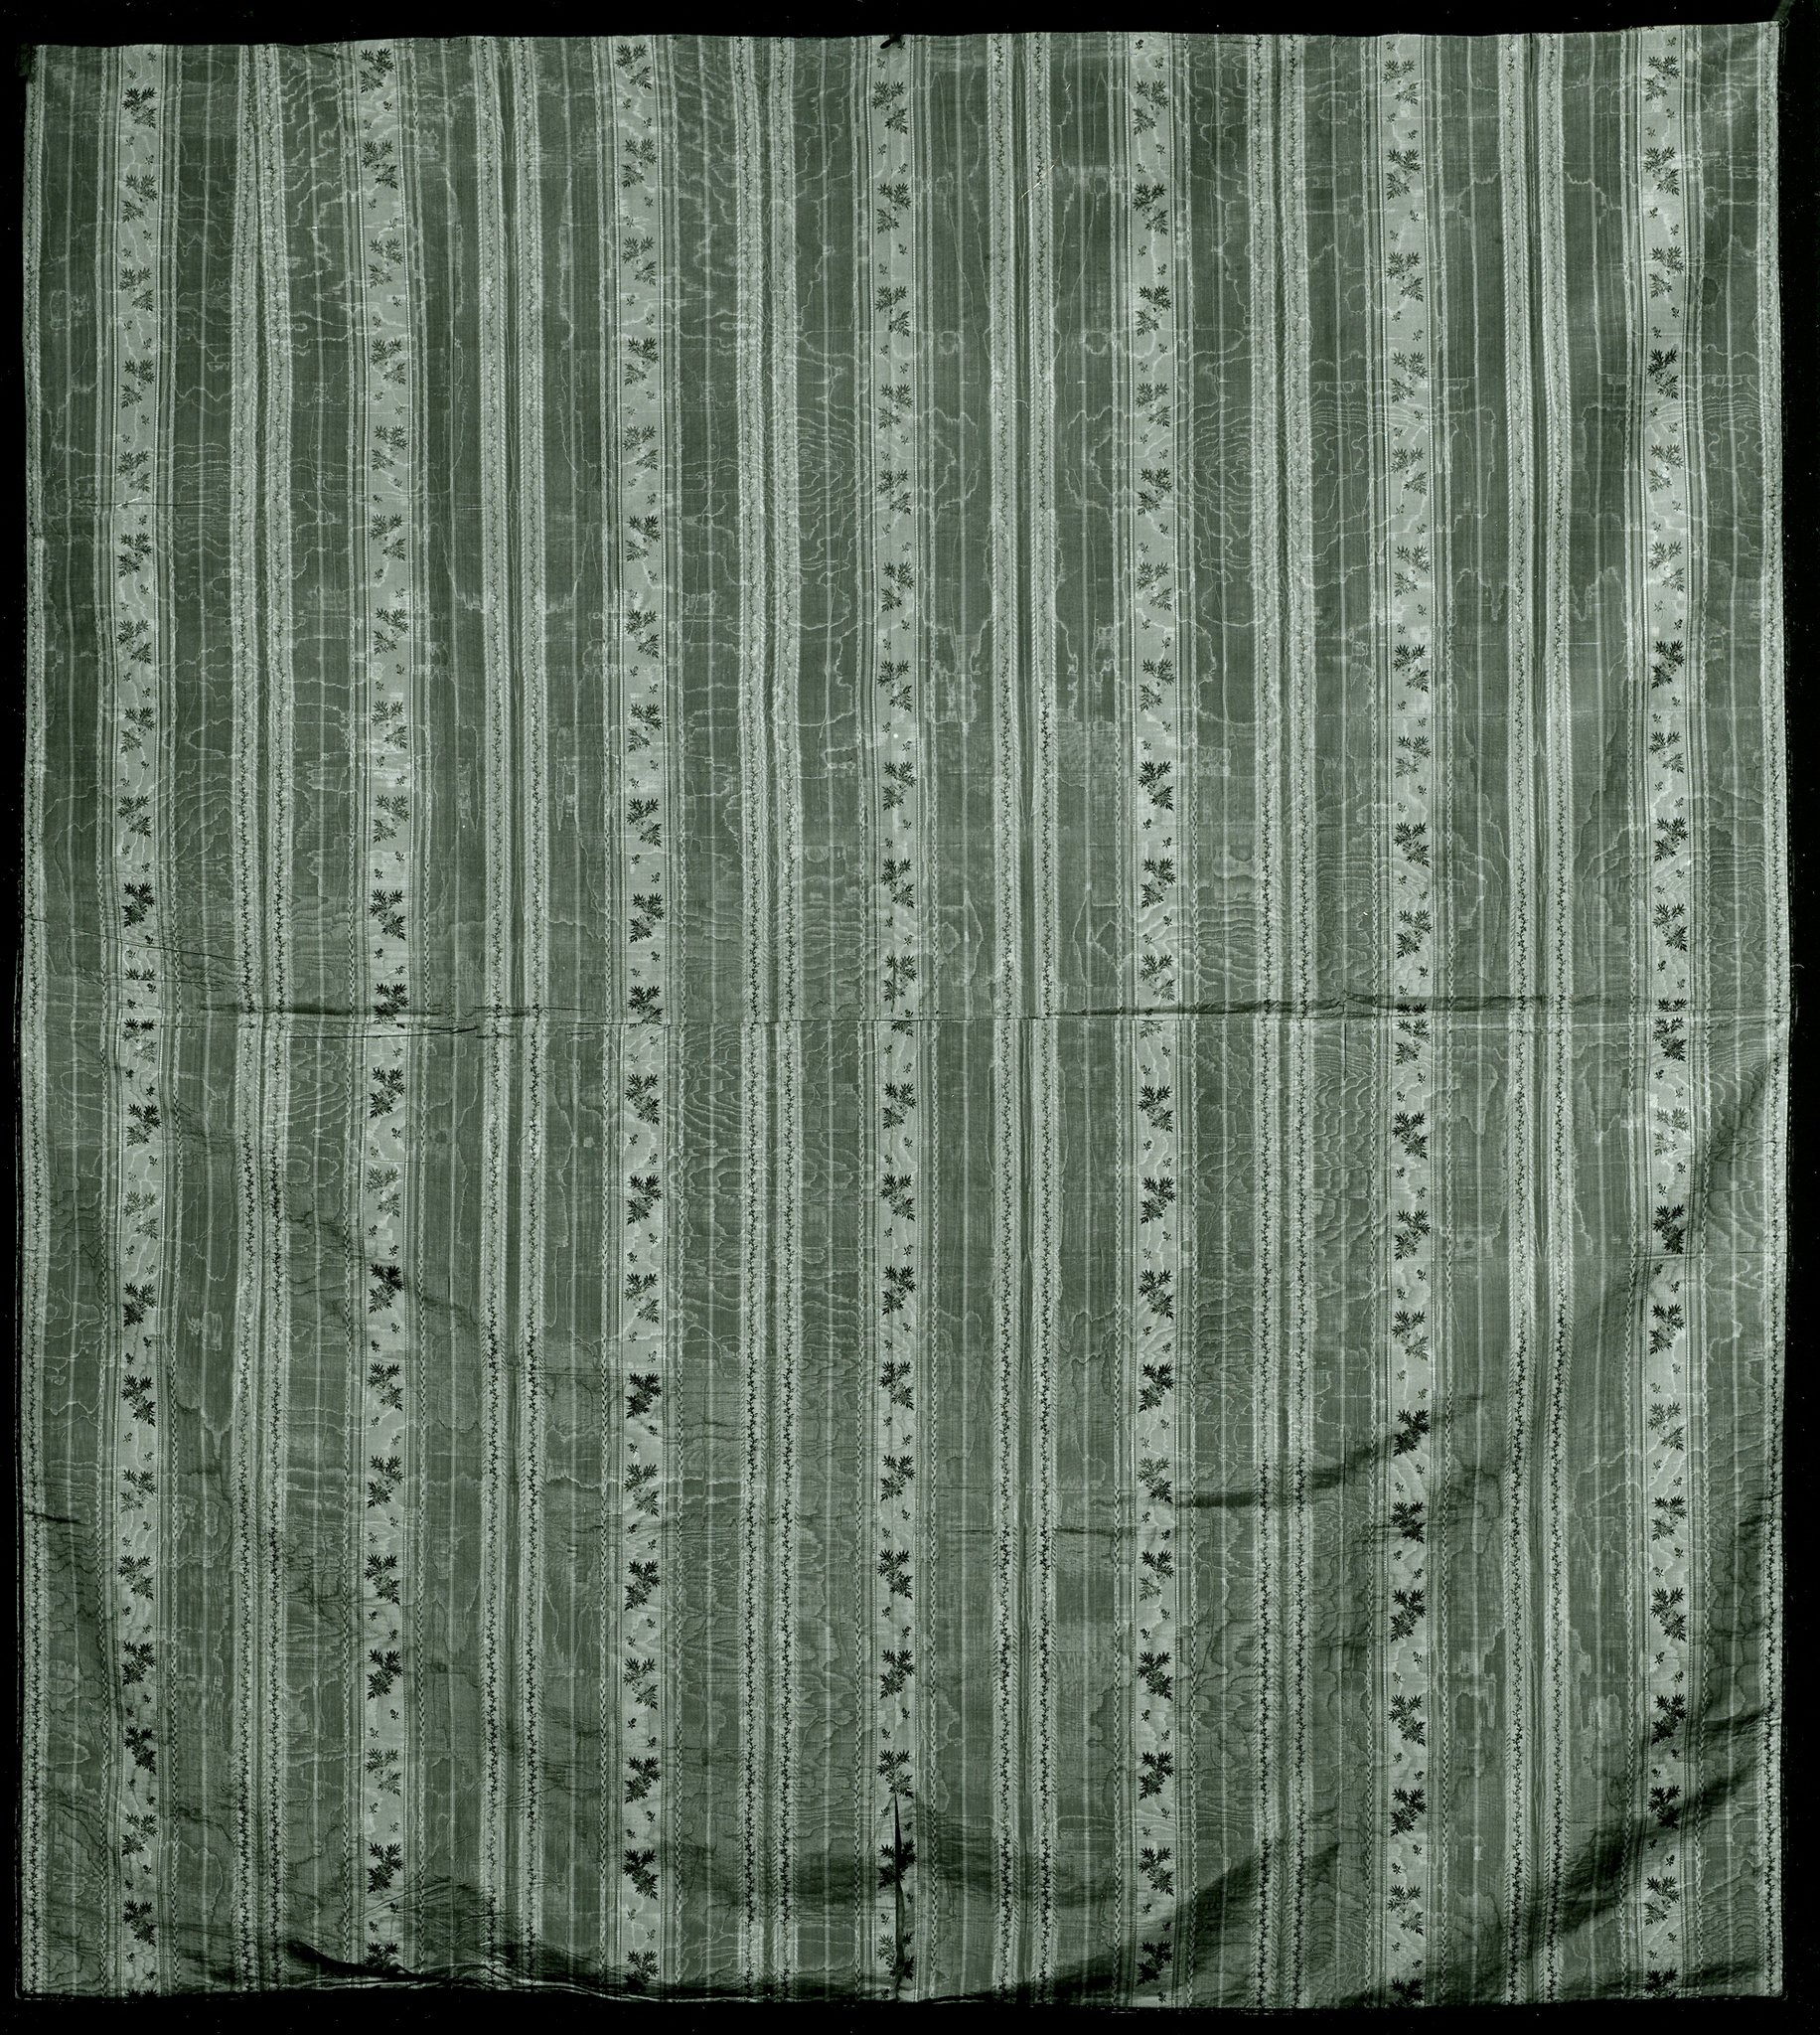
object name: orphrey, textile cover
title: Cover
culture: spanish or valencian or talavera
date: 1767-1800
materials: ink, linen, silk